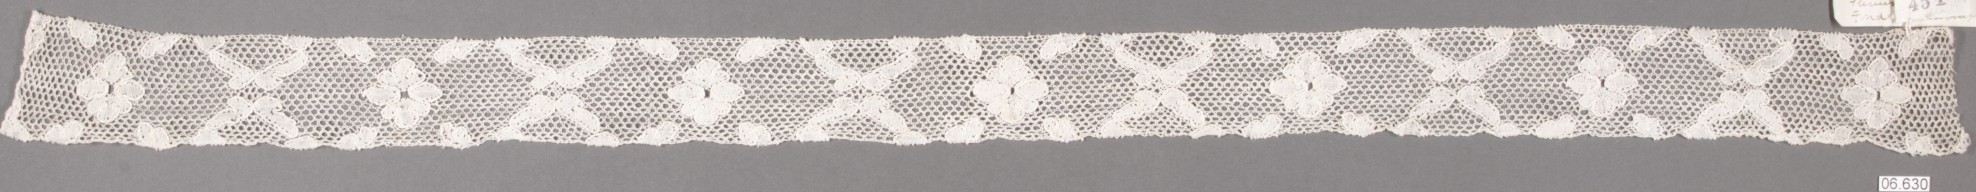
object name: fragment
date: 1800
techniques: lace